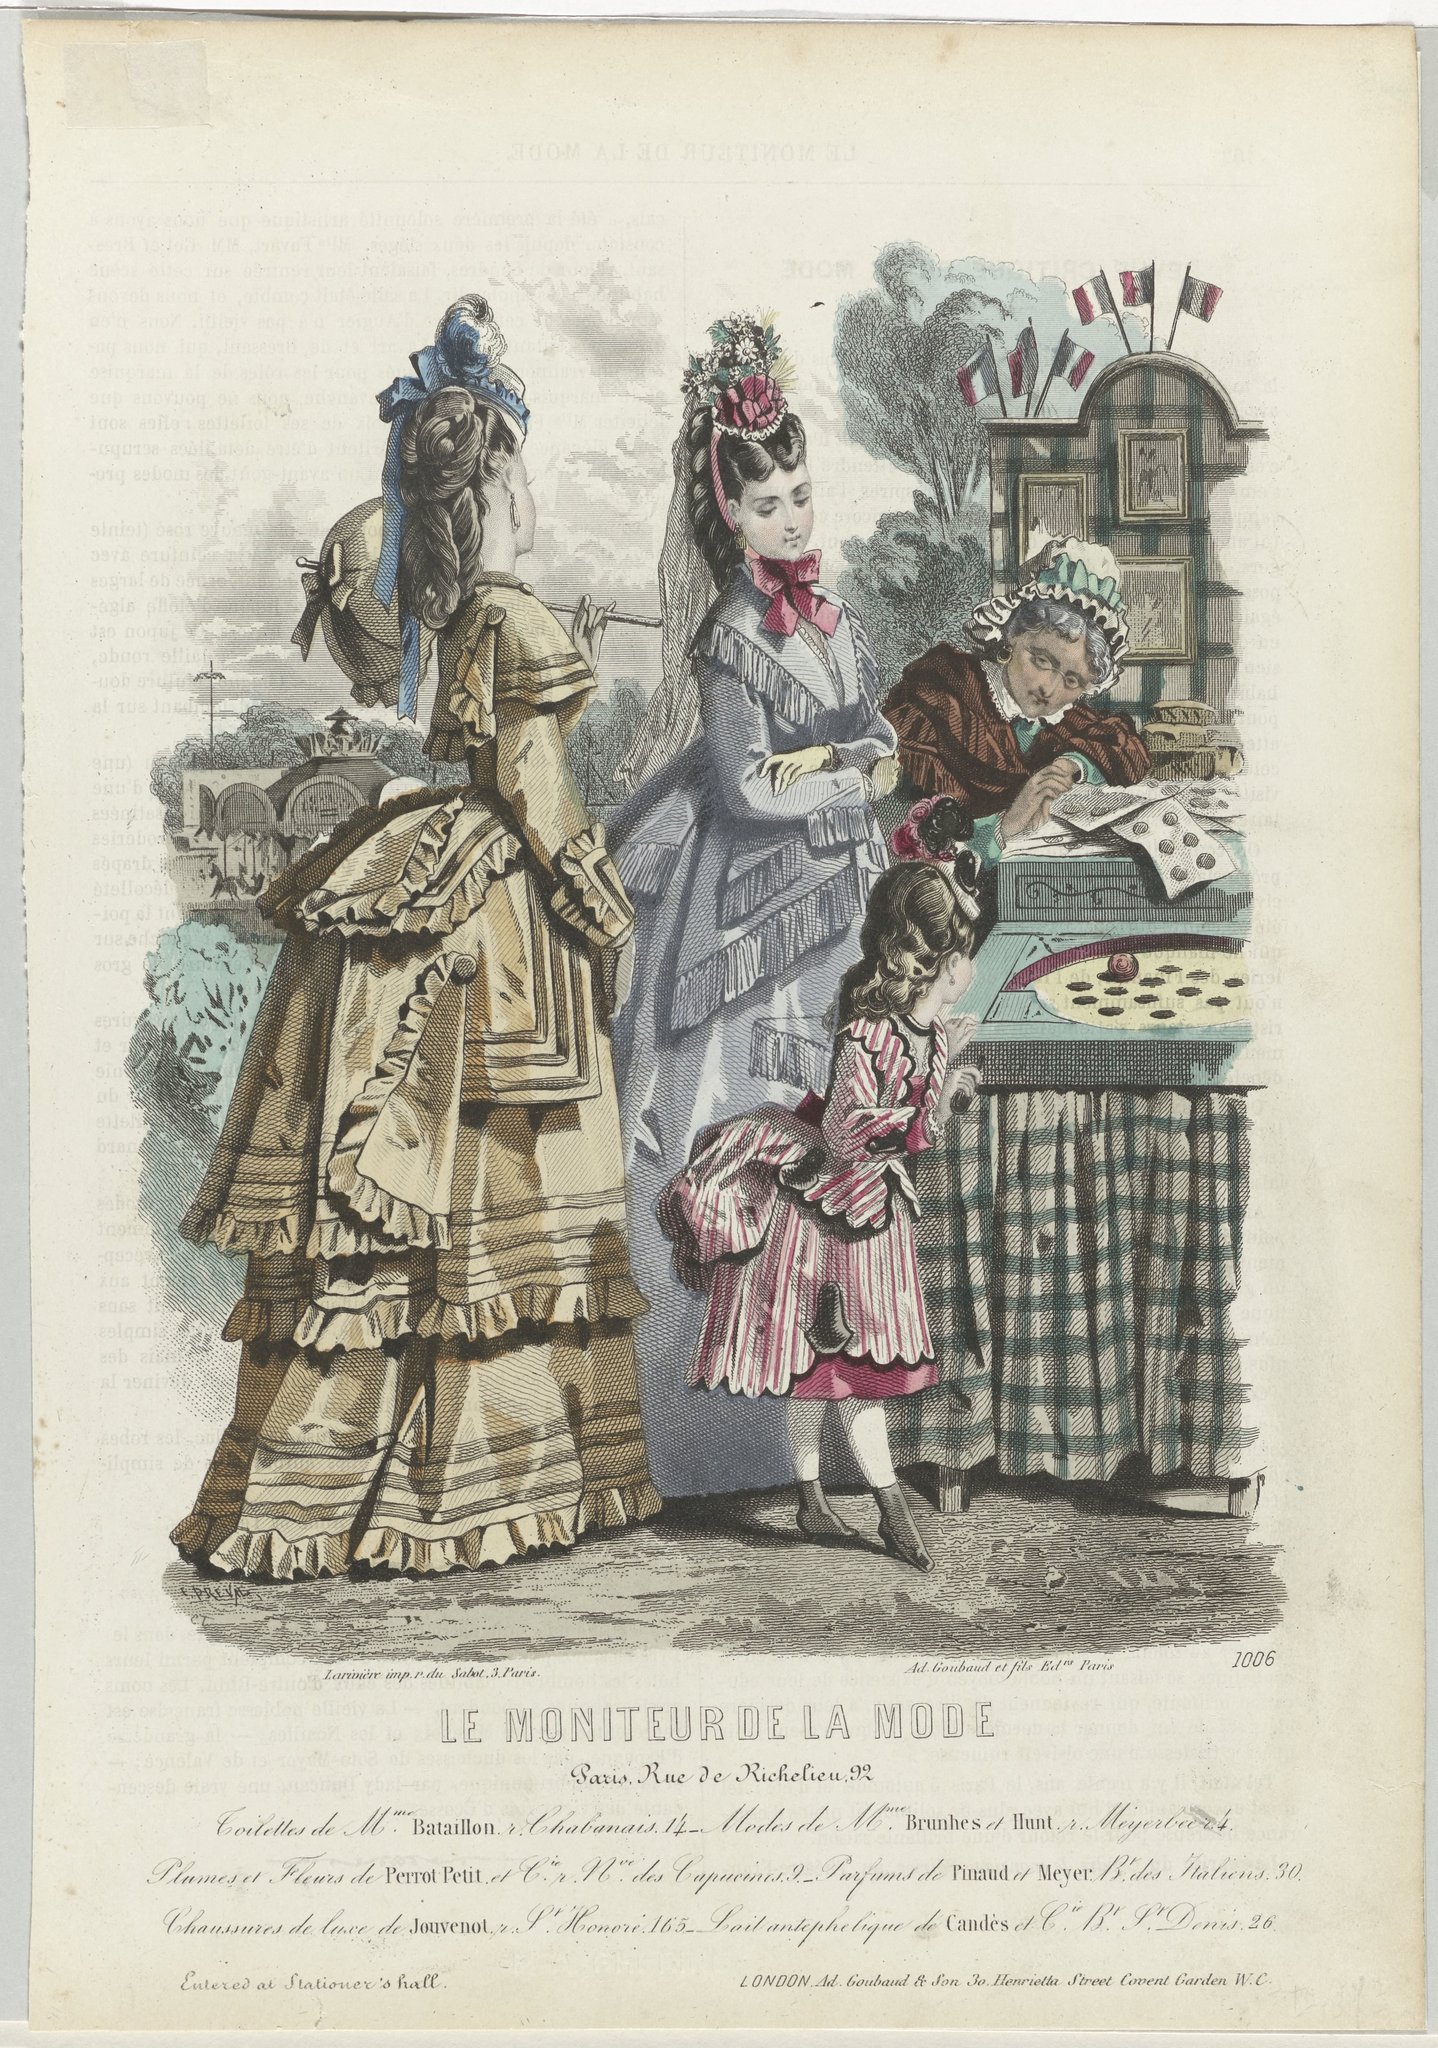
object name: fashion print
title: Le Moniteur de la Mode, 1871, No. 1006 : Toilettes de Mme Bataillon (...)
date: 1871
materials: paper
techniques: engraving, hand coloring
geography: paris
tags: merry-go-round, roundabout; chair o'plane, ear-rings (+ women's clothes), head-gear (+ girls' clothes), boots (+ girls' clothes), (children playing) pleasure-fair instruments, head-gear (+ women's clothes), fashion plates, dress, gown (+ women's clothes), parasol, sunshade (+ women's clothes), dress, gown (+ girls' clothes)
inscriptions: caption: ‘Toilettes de Mme Bataillon, r. Chabanais 14_ Modes de Mme Brunhes et Hunt r. Méyerbee r. 4. Plumes et Fleurs de Perrot Petit et Cie r. Nve des Capucines 9 _ Parfums de Pinaud et Meyer Bt des Italiens. 30. Chaussures de luxe de Jouvenot.r. St Honoré 165 _ Lait antephelique de Candès et Cie Bt St Denis 26.’, address: ‘Paris, Rue de Richelieu, 92. / Entered at Stationer's Hall / London Ad. Goubaud & Son 30. Henrietta Street Covent Garden W.C>’, title: ‘Le Moniteur de la Mode’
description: Twee vrouwen en een meisje op kermis, gekleed in japonnen van Bataillon met tournure. In het onderschrift volgen enkele regels reclametekst voor verschillende producten. Prent uit het modetijdschrift Le Moniteur de la Mode (1843-1913).